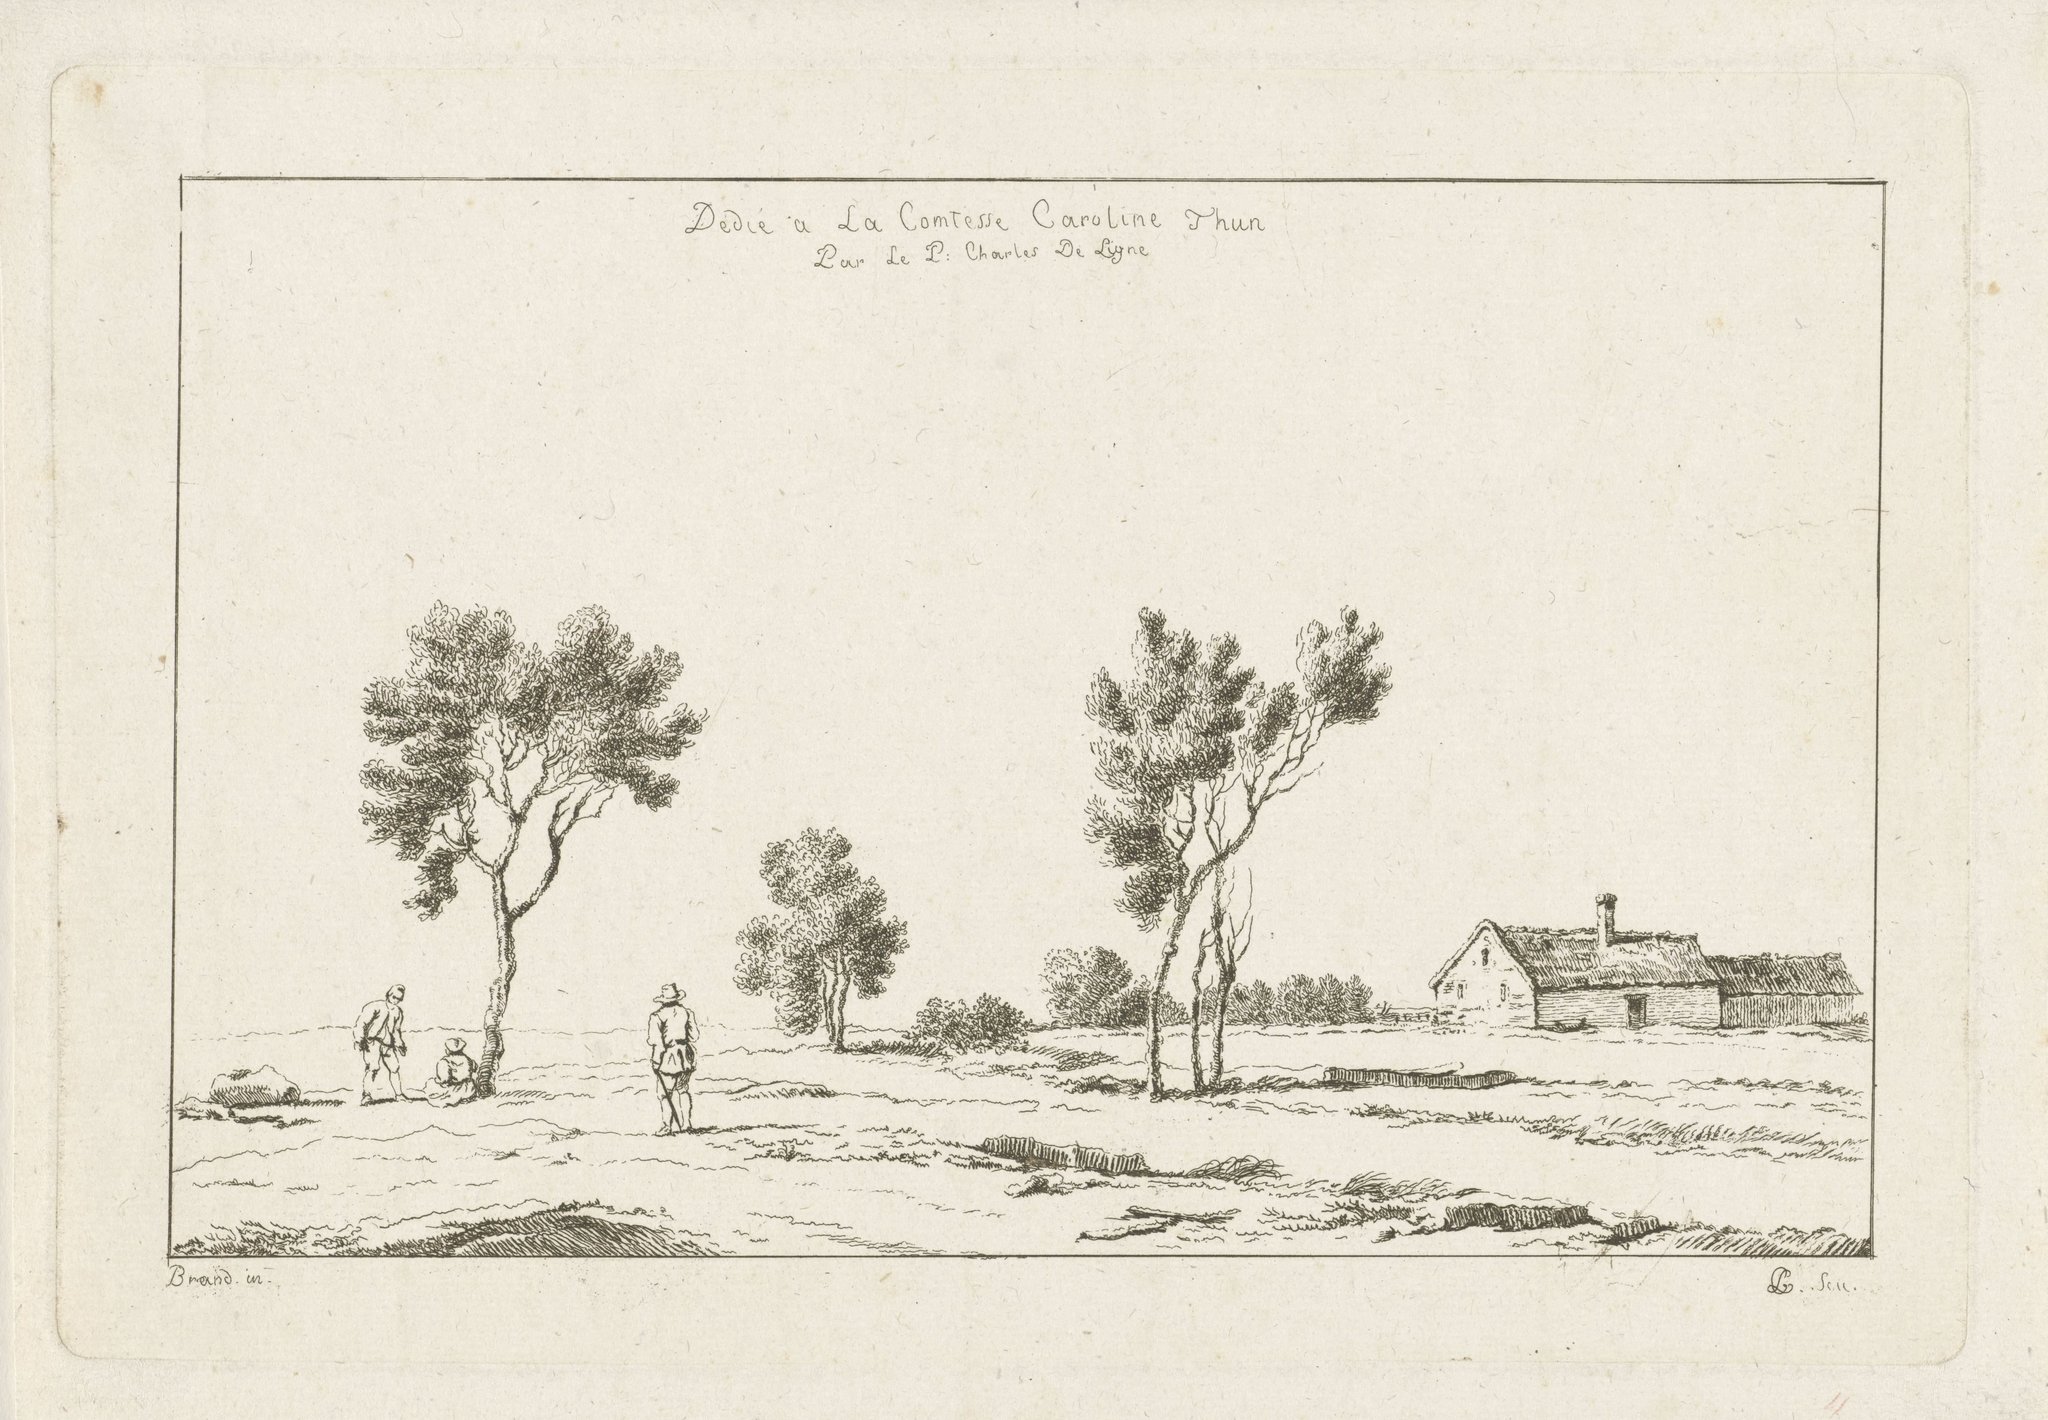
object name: print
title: Landschap met boerderij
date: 1774-1792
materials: paper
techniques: etching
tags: farm or solitary house in landscape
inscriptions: collector's mark: Lugt 2228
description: Landschap met een boerderij. Links twee converserende figuren bij een boom, een derde loopt naar deze figuren toe.